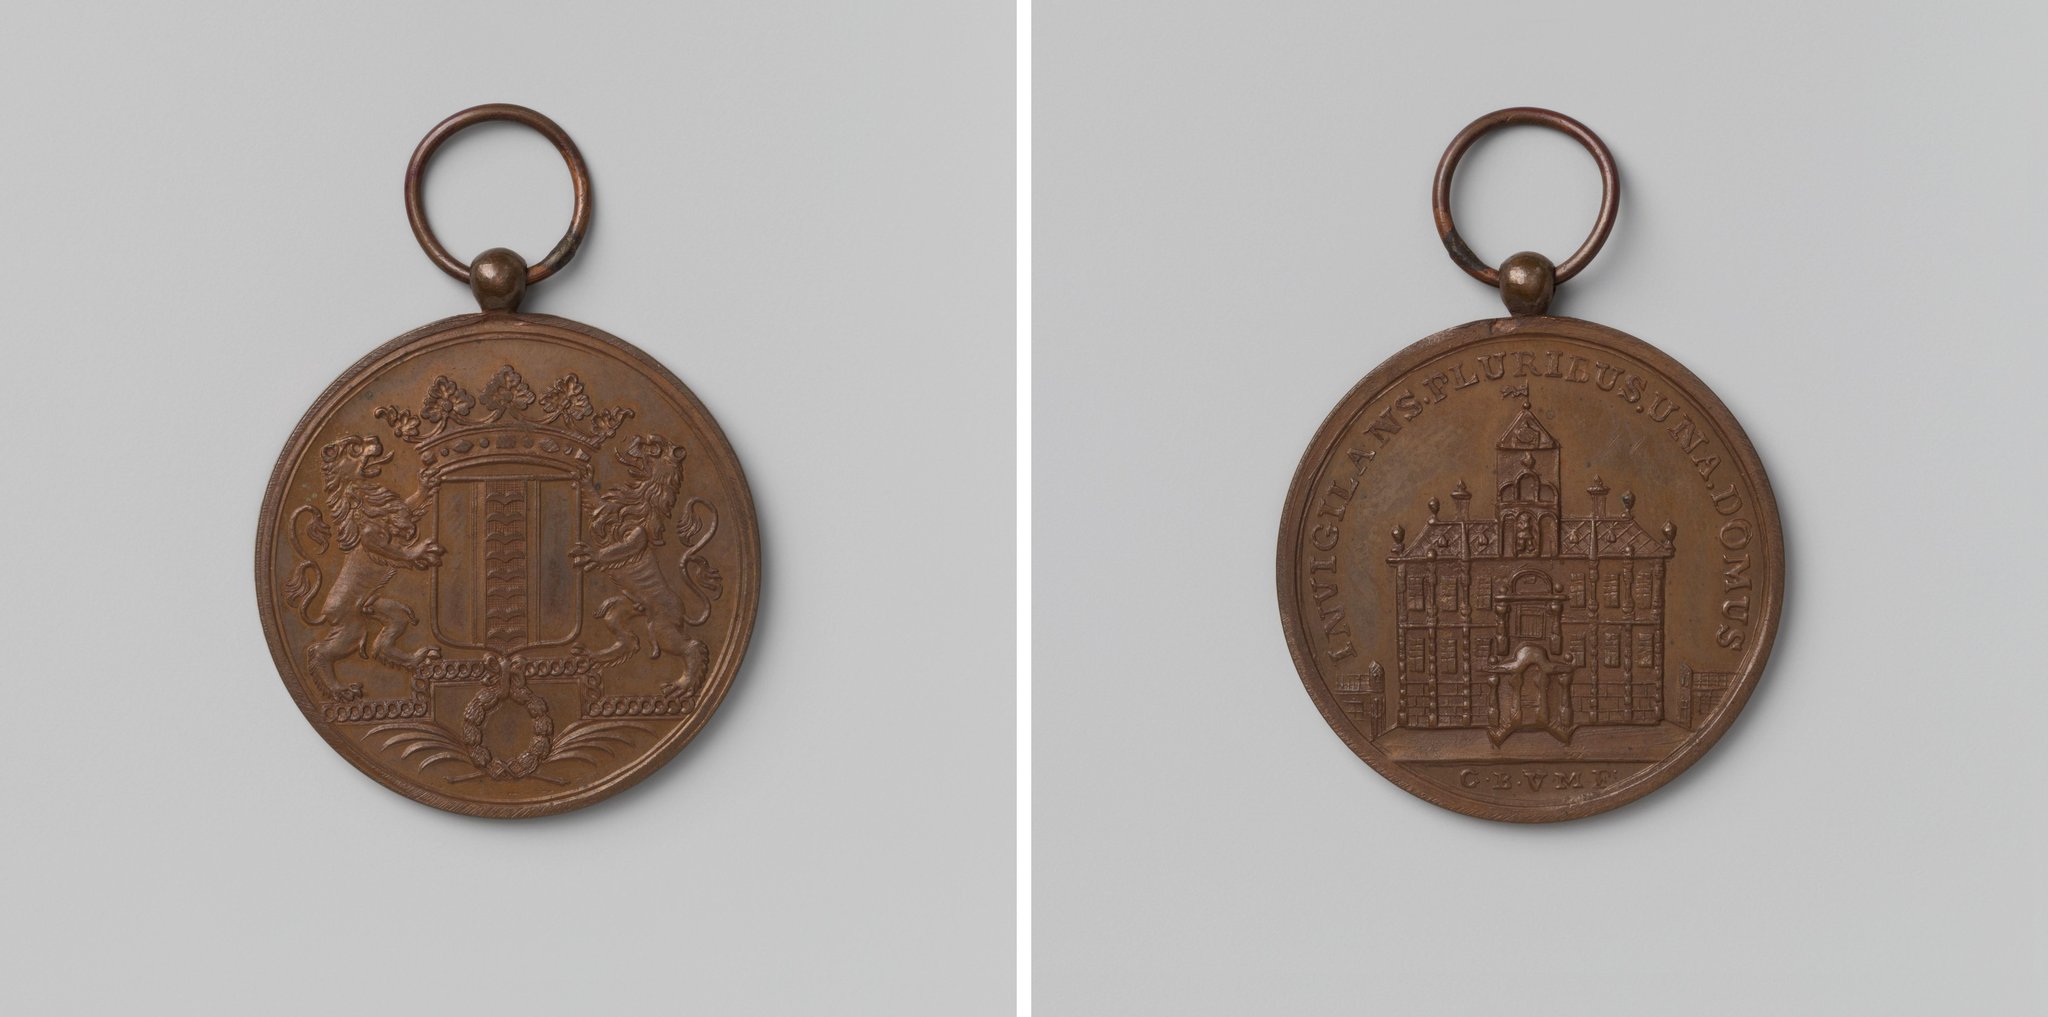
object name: council medal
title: Vroedschapspenning van de stad Delft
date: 1775-1783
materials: bronze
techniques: striking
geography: the hague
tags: delft